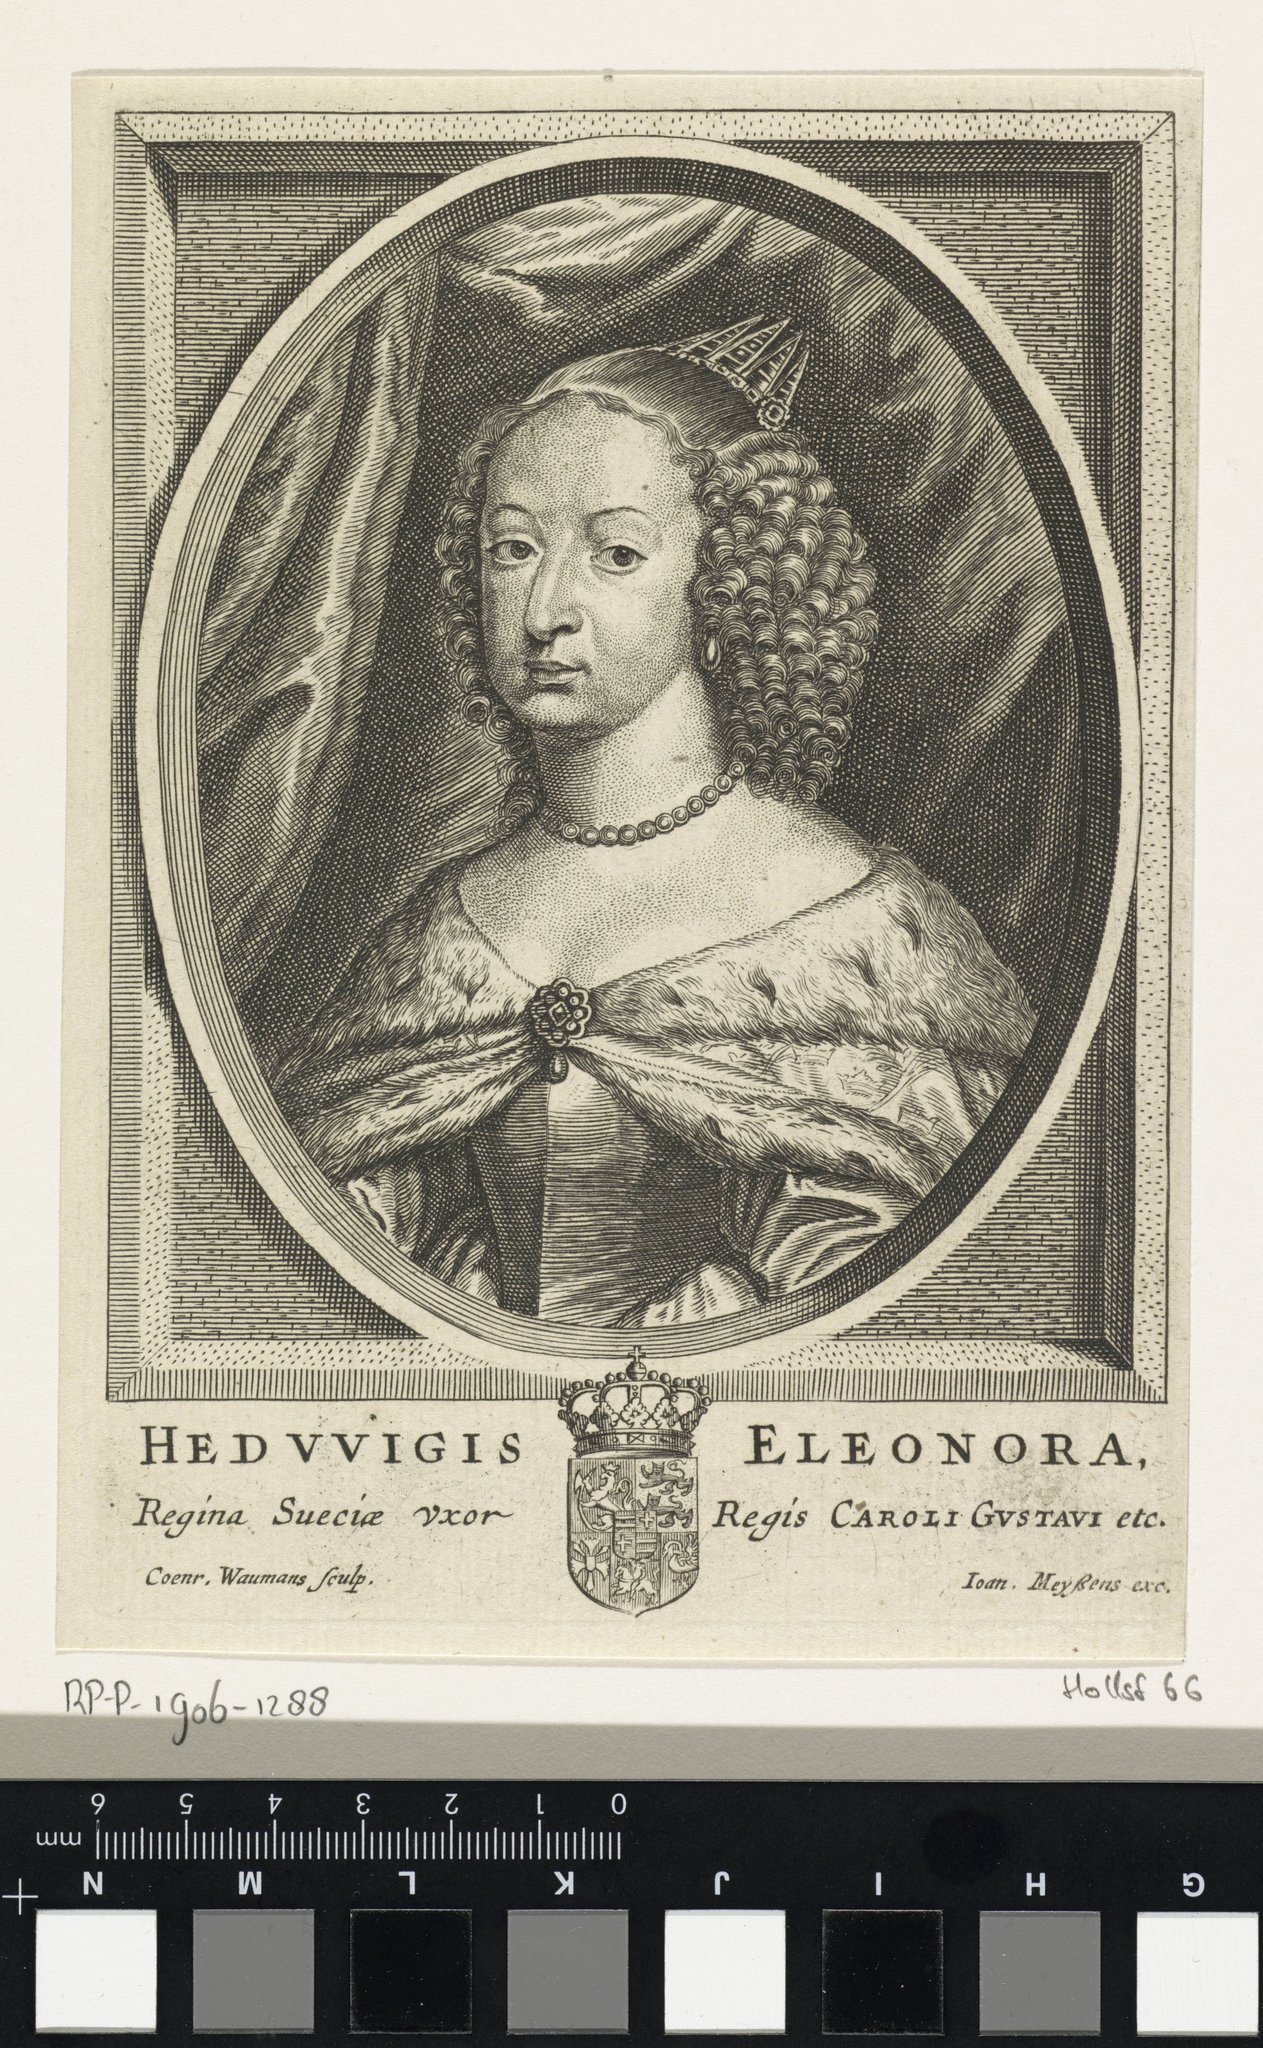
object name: print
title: Theatrum pontificum, imperatorum, regum, ducum, principum, etc.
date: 1633-1673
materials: paper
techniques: engraving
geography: antwerp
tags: armorial bearing, heraldry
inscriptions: collector's mark: Lugt 2228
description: Portret van Hedwig Eleonora, koningin van Zweden. In de marge haar wapenschild en tweeregelig onderschrift in het Latijn.